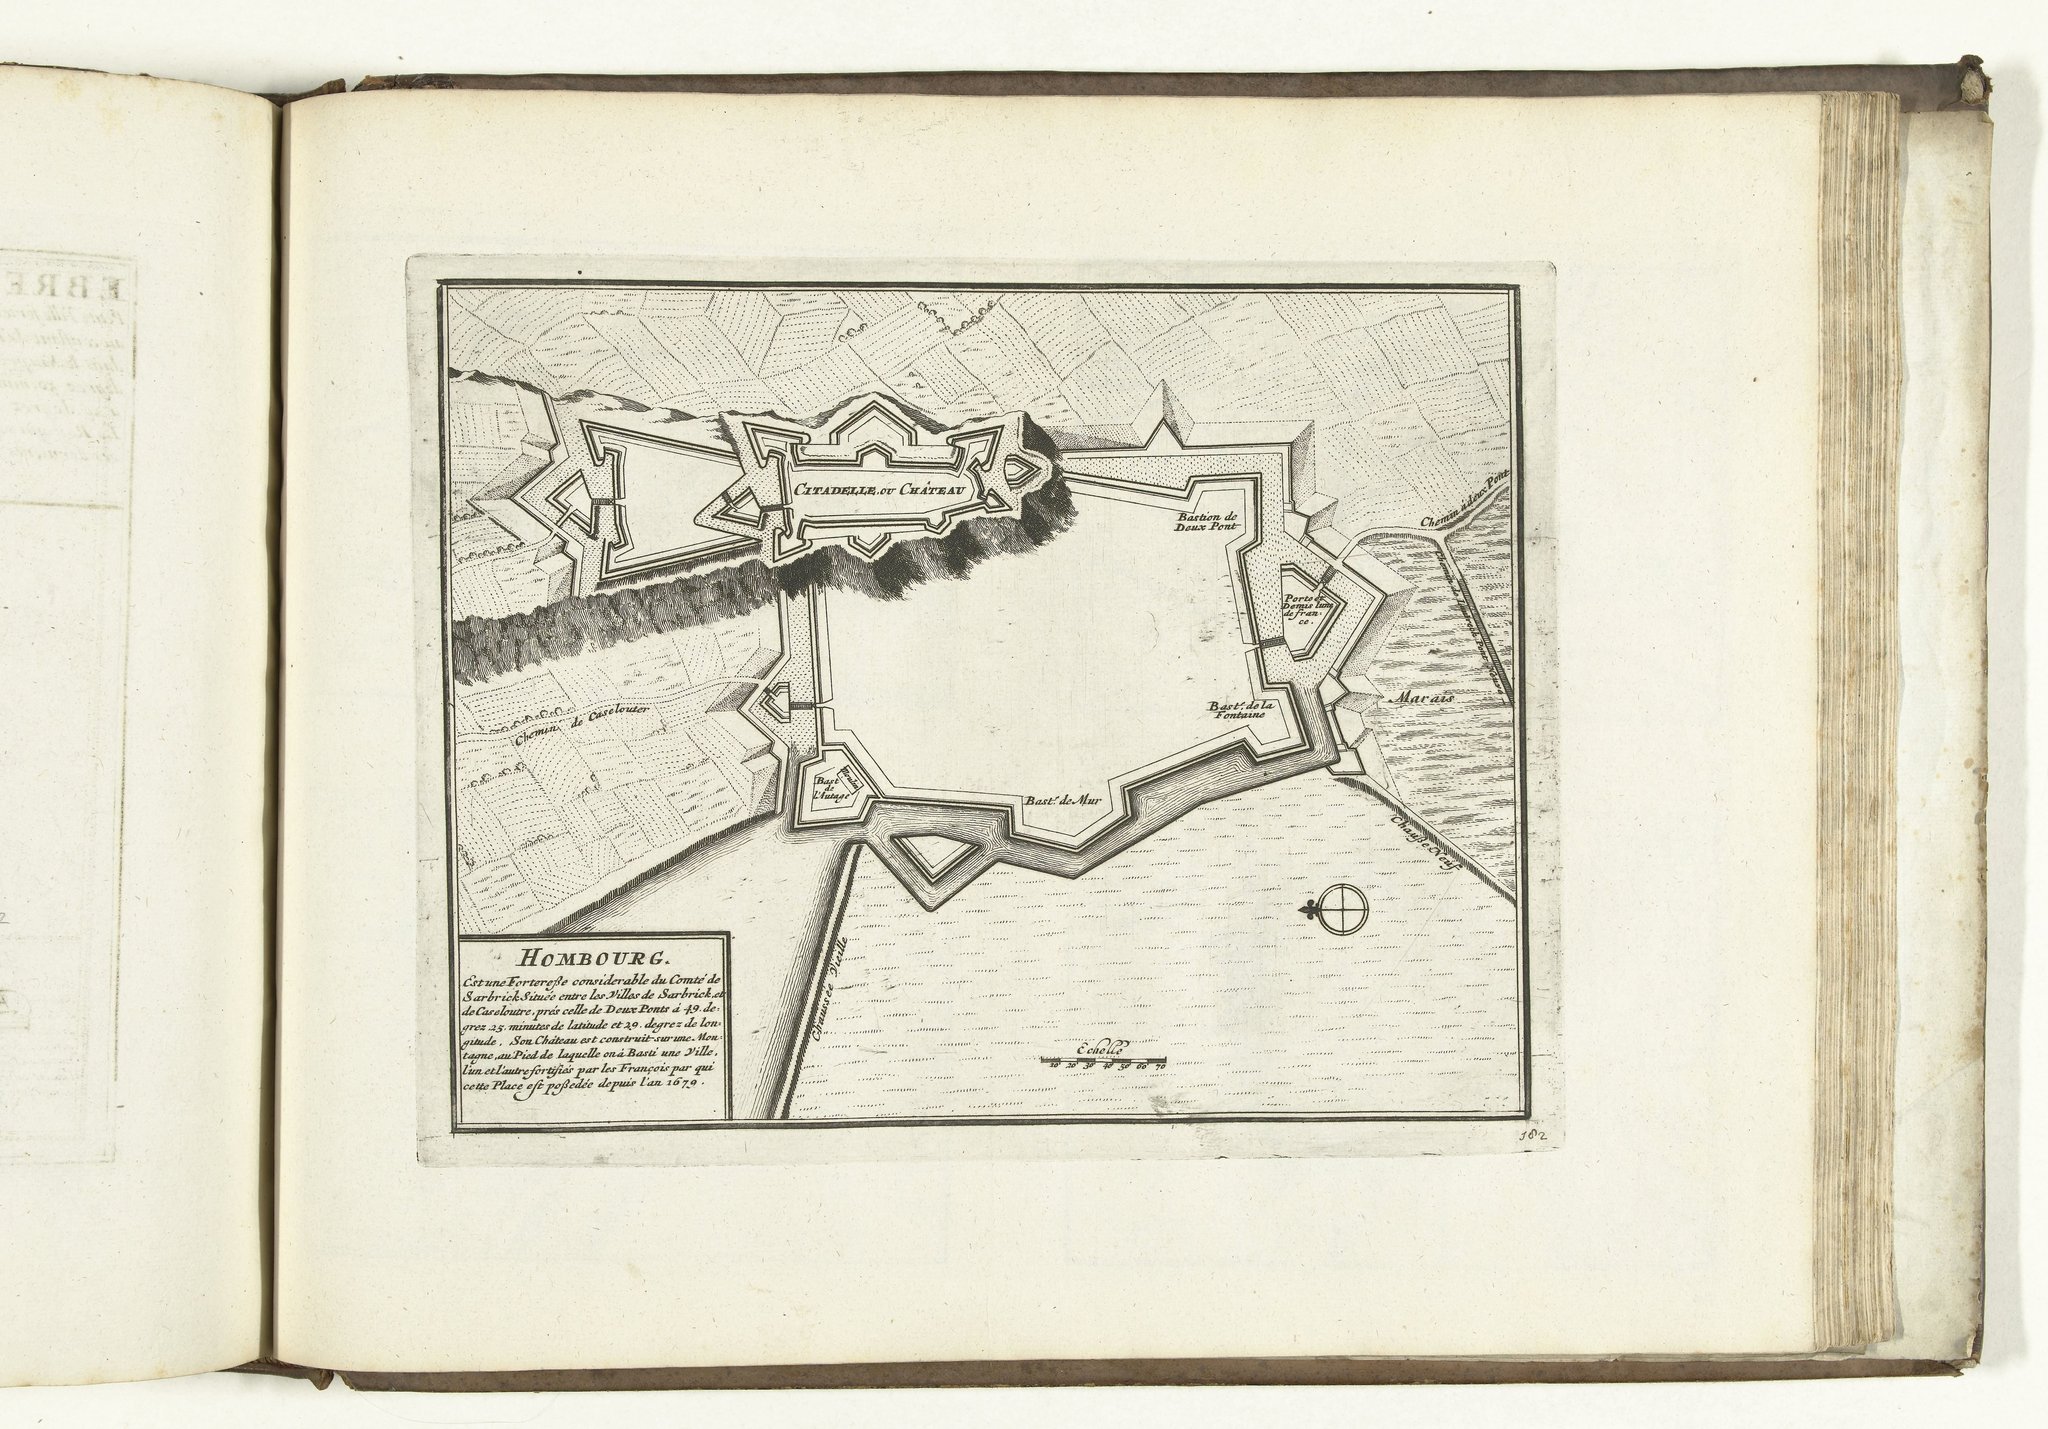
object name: print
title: Hombourg. Est une Fortresse considerable du Comté de Sarbrick (...)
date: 1726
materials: paper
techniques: etching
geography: northern netherlands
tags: fortress, maps of cities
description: Plattegrond van de versterkingen om de Duitse stad Homburg. Plaat nr. 182 in deel VIII van het prentwerk: Les Forces de l'Europe, Asie, Afrique et Amerique ... Comme aussi les Cartes des Côtes de France et d'Espagne uit 1726, dit eerste deel met 238 met de hand genummerde platen van vermaarde sterke steden en vestingen in het kader van de Spaanse Successieoorlog 1701-1713. Voor het merendeel zijn deze platen gekopieerd naar de anonieme Franse platen van vermaarde sterke steden en vestingen: in Les forces de l'Europe en in: Le theatre de la guerre, dans les Pays-Bas, beide oorspronkelijk uitgegeven door Nicolas de Fer te Parijs (1693-1697) in het kader van de Negenjarige Oorlog. Titel en opschriften in het Frans. Rechtsonder sporen van het weggepolijste nummer: 131.